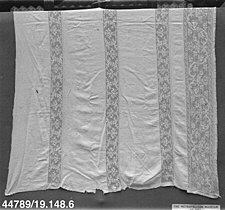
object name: bed hanging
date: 1501-1700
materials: linen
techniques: embroidery